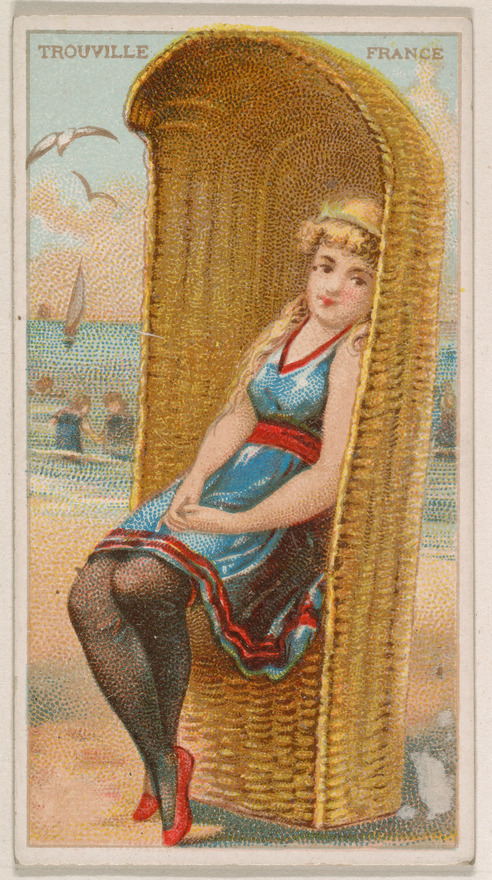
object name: print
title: Trouville, France, from the Surf Beauties series (N232), issued by Kinney Bros.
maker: kinney brothers tobacco company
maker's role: publisher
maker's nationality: american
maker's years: 1869-2011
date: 1889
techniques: color lithograph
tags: women,sports